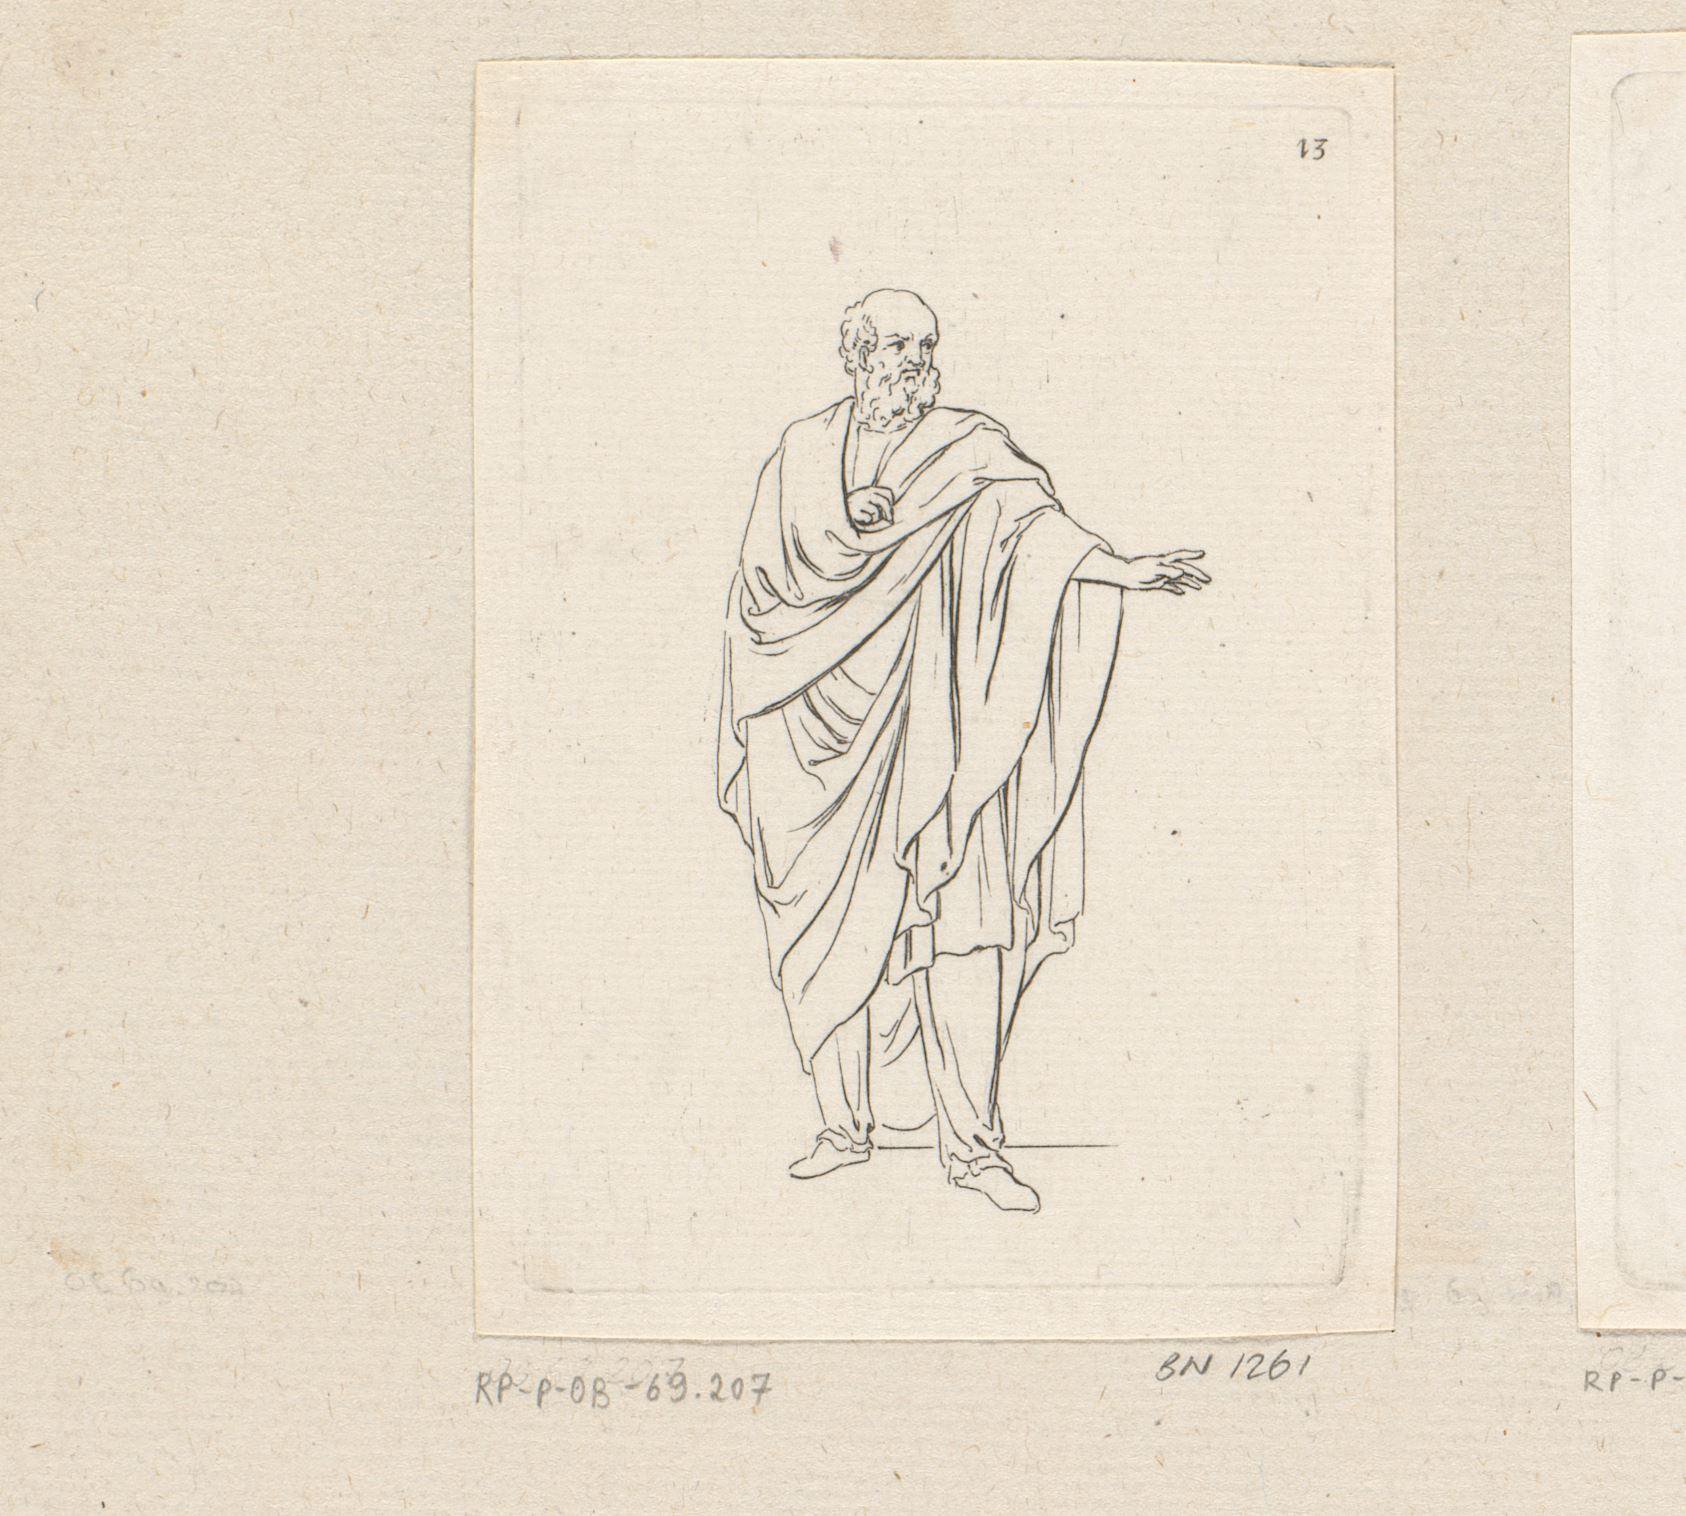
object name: print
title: Bebaarde man met opgeheven linkerarm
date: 1706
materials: paper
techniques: etching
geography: france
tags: adult man